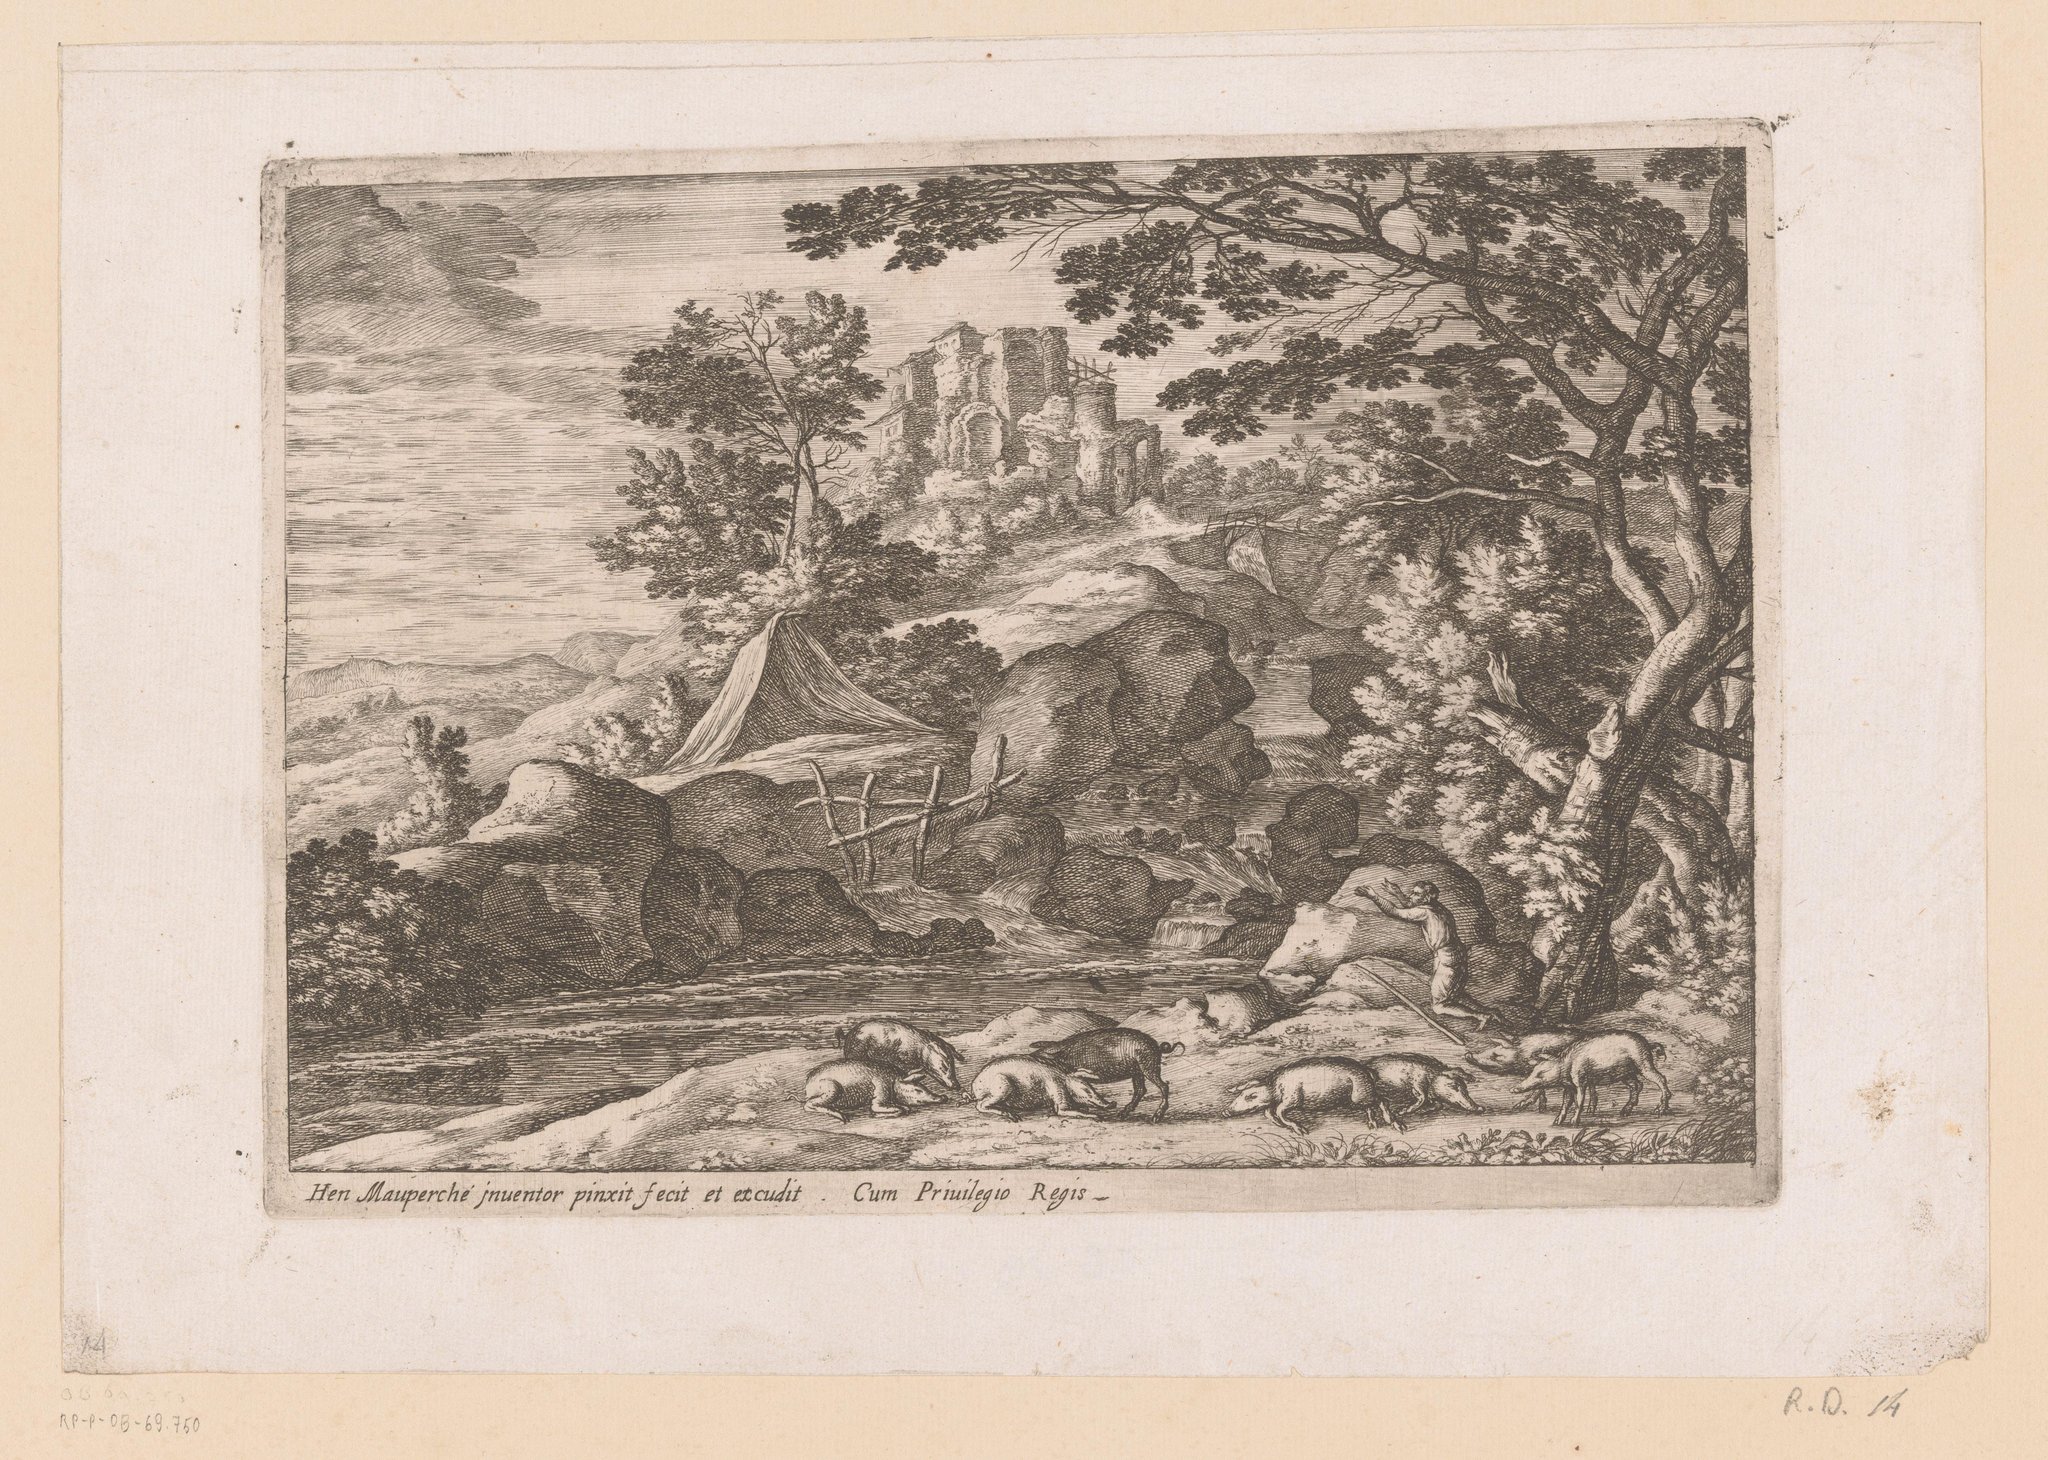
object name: print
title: Verloren zoon die de varkens hoedt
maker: henri mauperché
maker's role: painter, print maker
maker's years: 1602-1686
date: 1612-1686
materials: paper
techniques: engraving, etching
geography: paris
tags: the prodigal son tends the swine and eats from their trough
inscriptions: collector's mark: Lugt 240